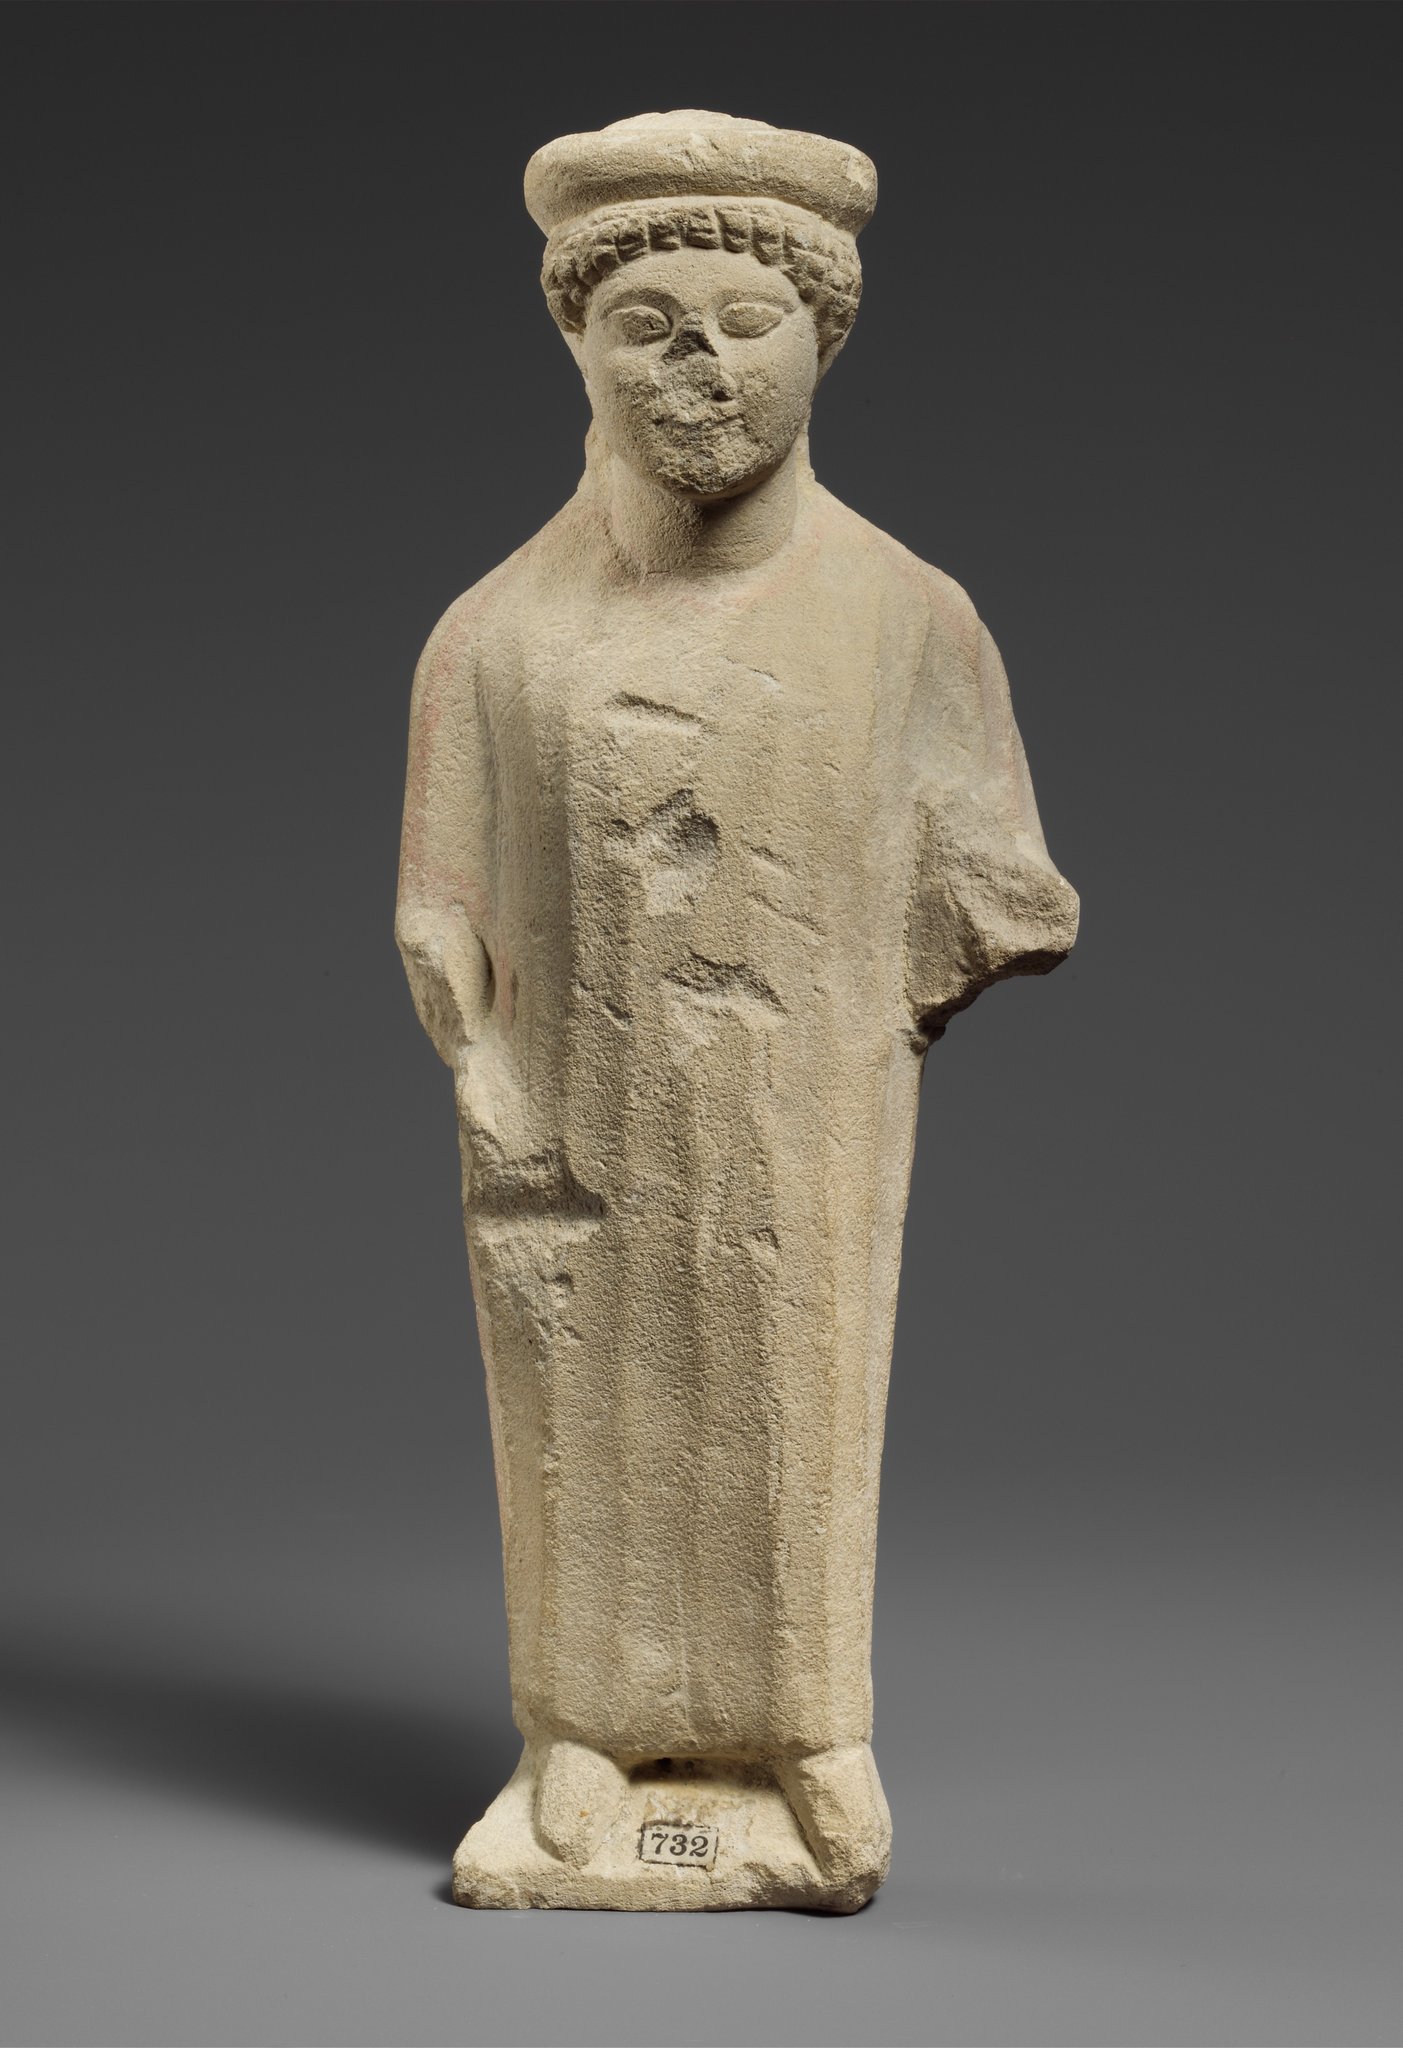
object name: statue of a votary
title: Limestone statuette of a boy with a flat headdress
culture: cypriot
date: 600-501 BCE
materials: limestone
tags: boys